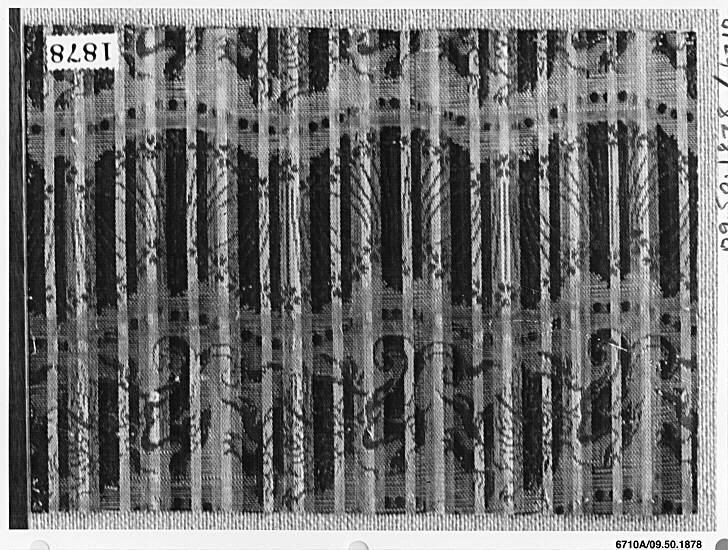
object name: piece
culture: japanese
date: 1615-1868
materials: silk